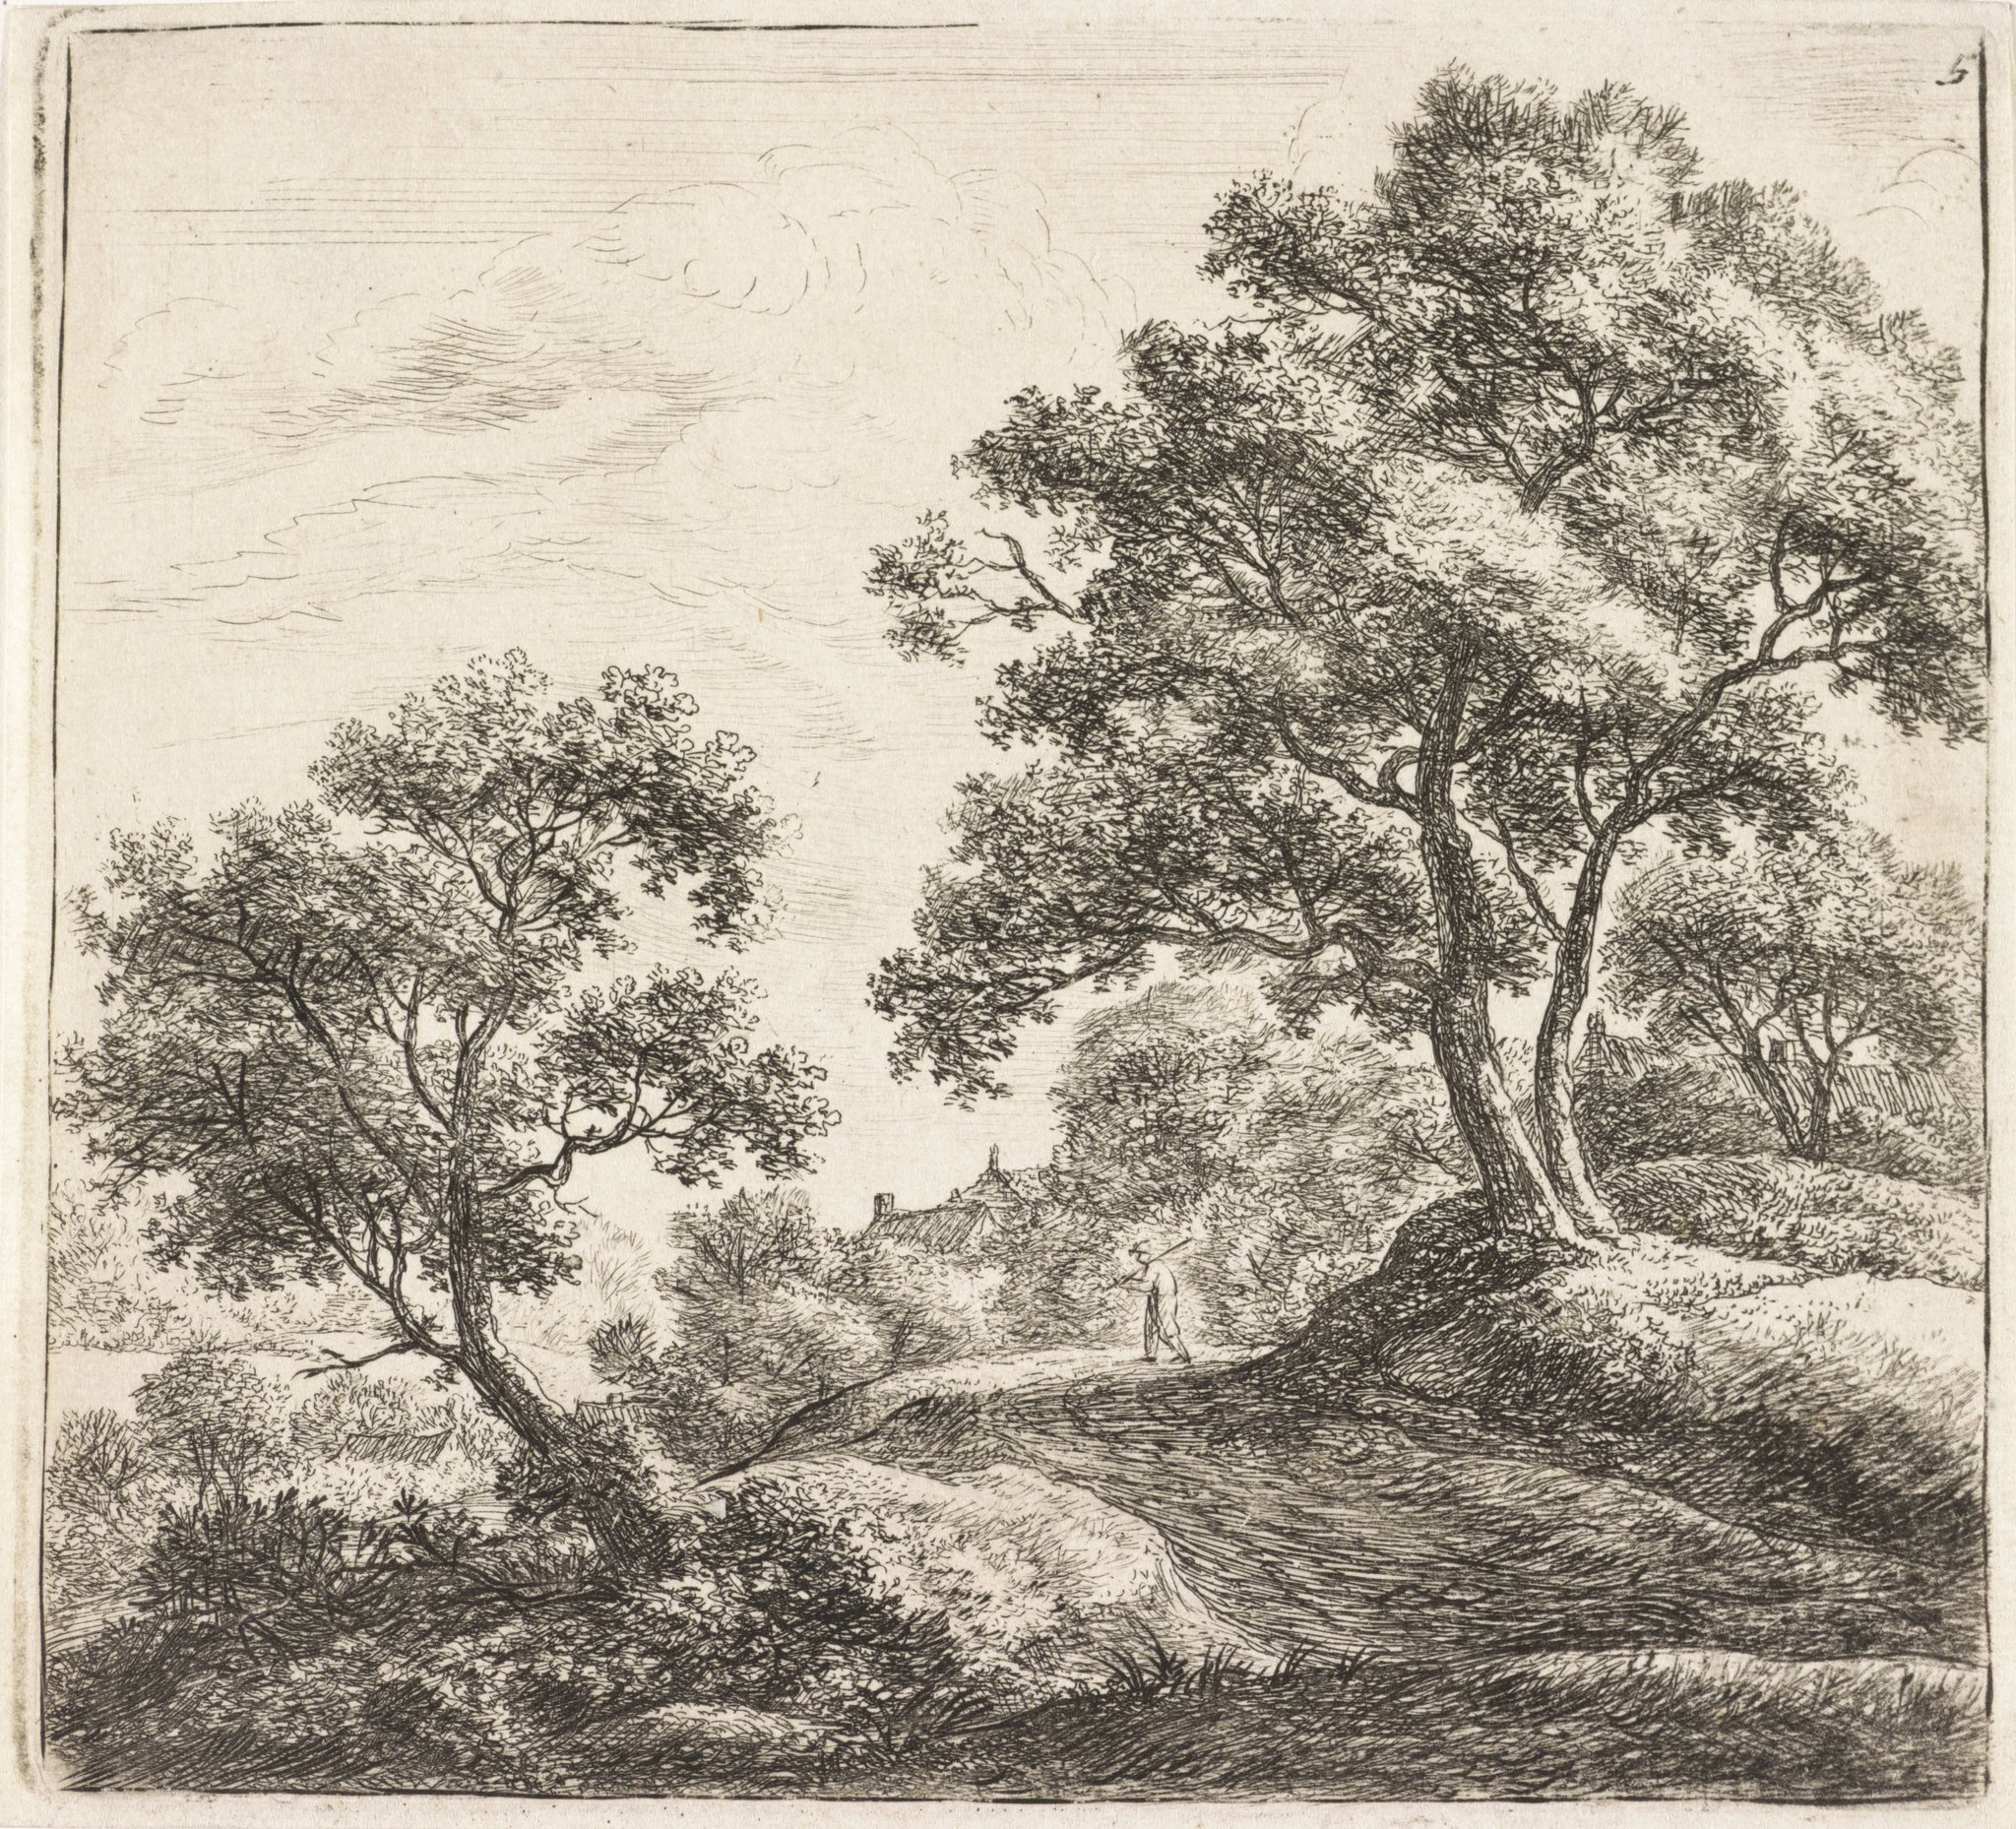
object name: print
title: Man op een pad bij een dorp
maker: anthonie waterloo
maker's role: draughtsman, painter, print maker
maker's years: 1609-1690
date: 1630-1663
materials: paper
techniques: etching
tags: village, forest path or lane, landscapes (+ landscape with figures, staffage)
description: Een man loopt op een pad met aan weerszijden bomen. In de verte ligt een dorp.